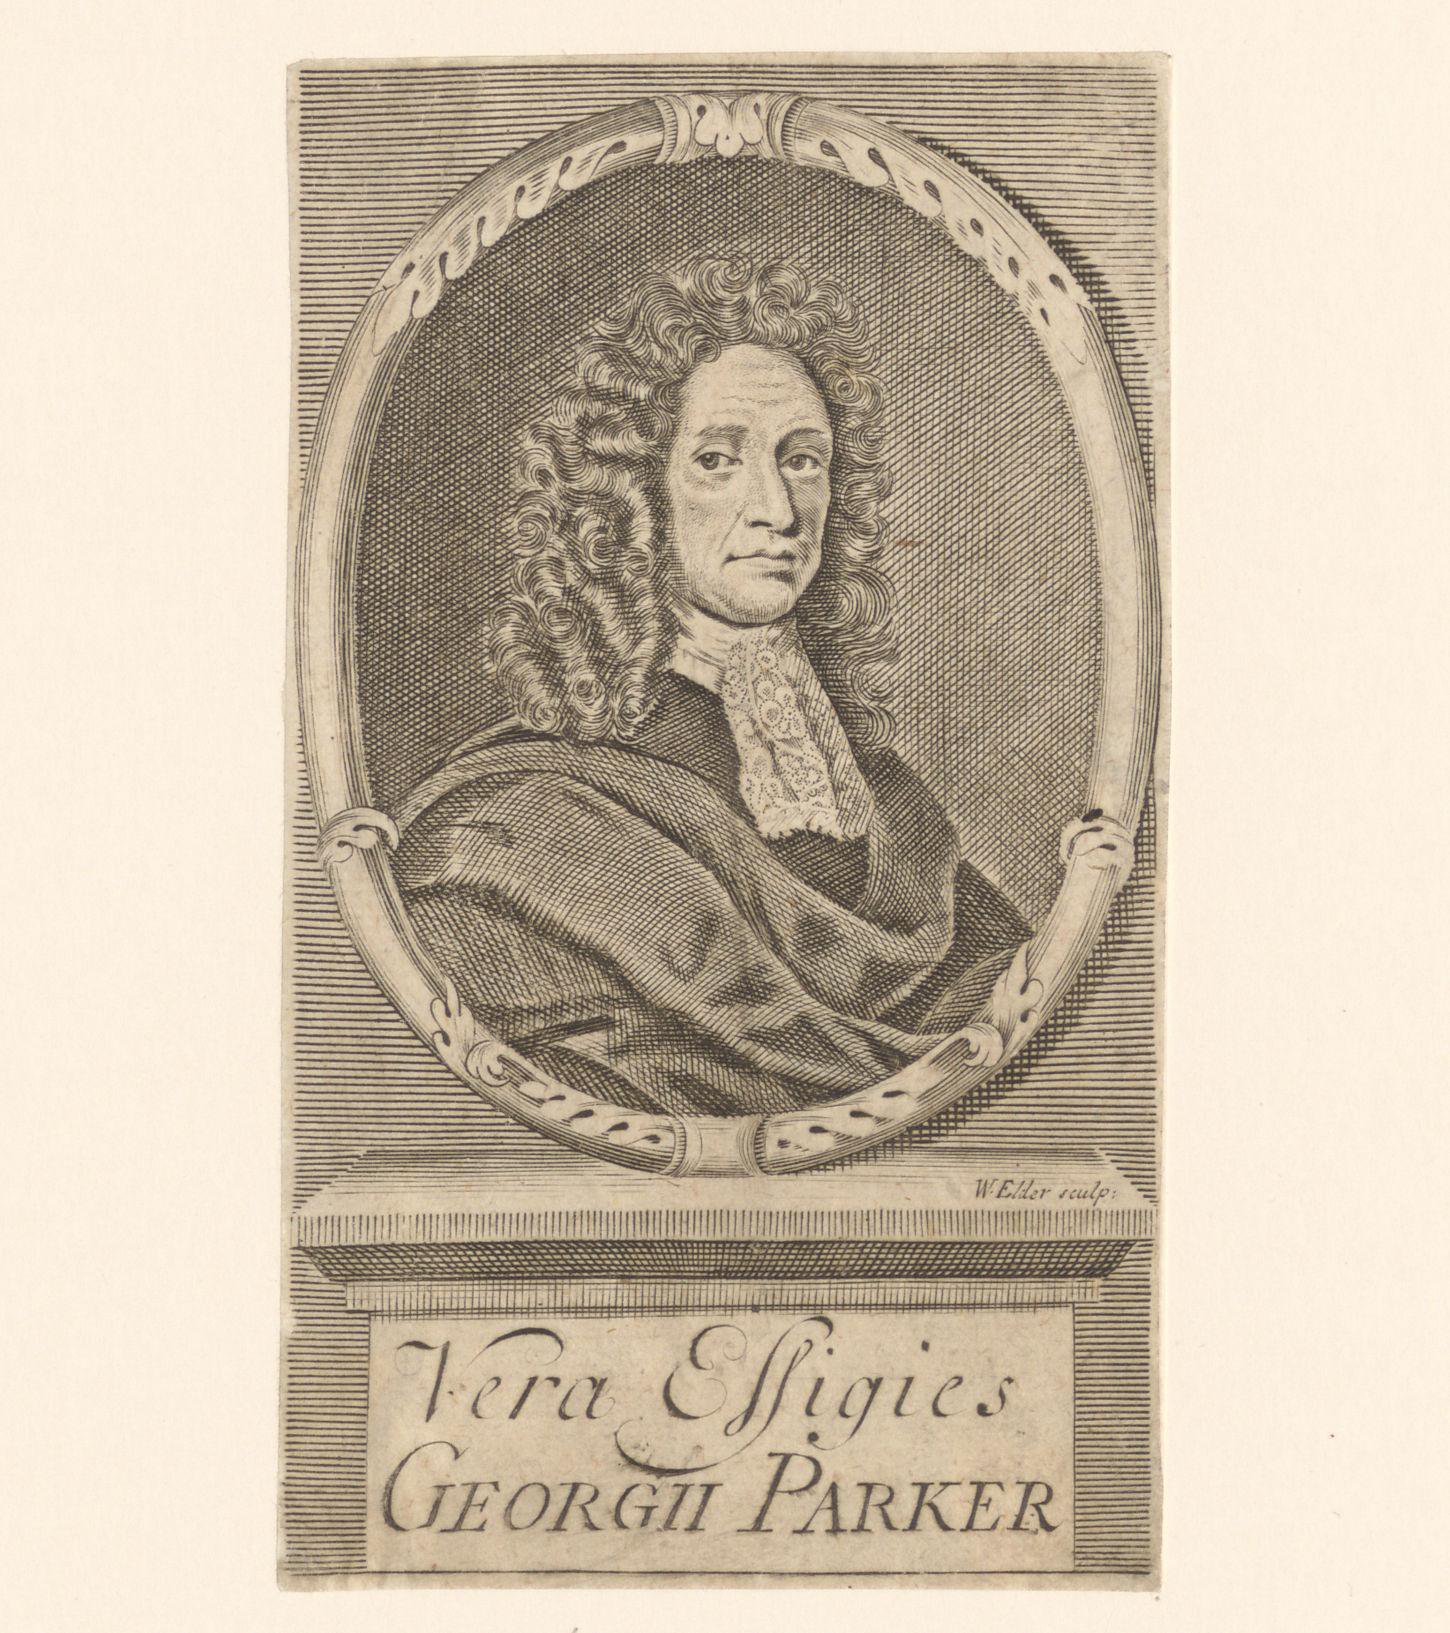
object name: book illustration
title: Portret van George Parker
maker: william elder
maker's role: print maker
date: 1694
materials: paper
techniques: engraving, etching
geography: london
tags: george parker, historical persons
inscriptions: collector's mark: Lugt 2228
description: Prent uit: Parker, George. Mercurius Anglicanus or The English Mercury (...). Londen: s.n., 1694.